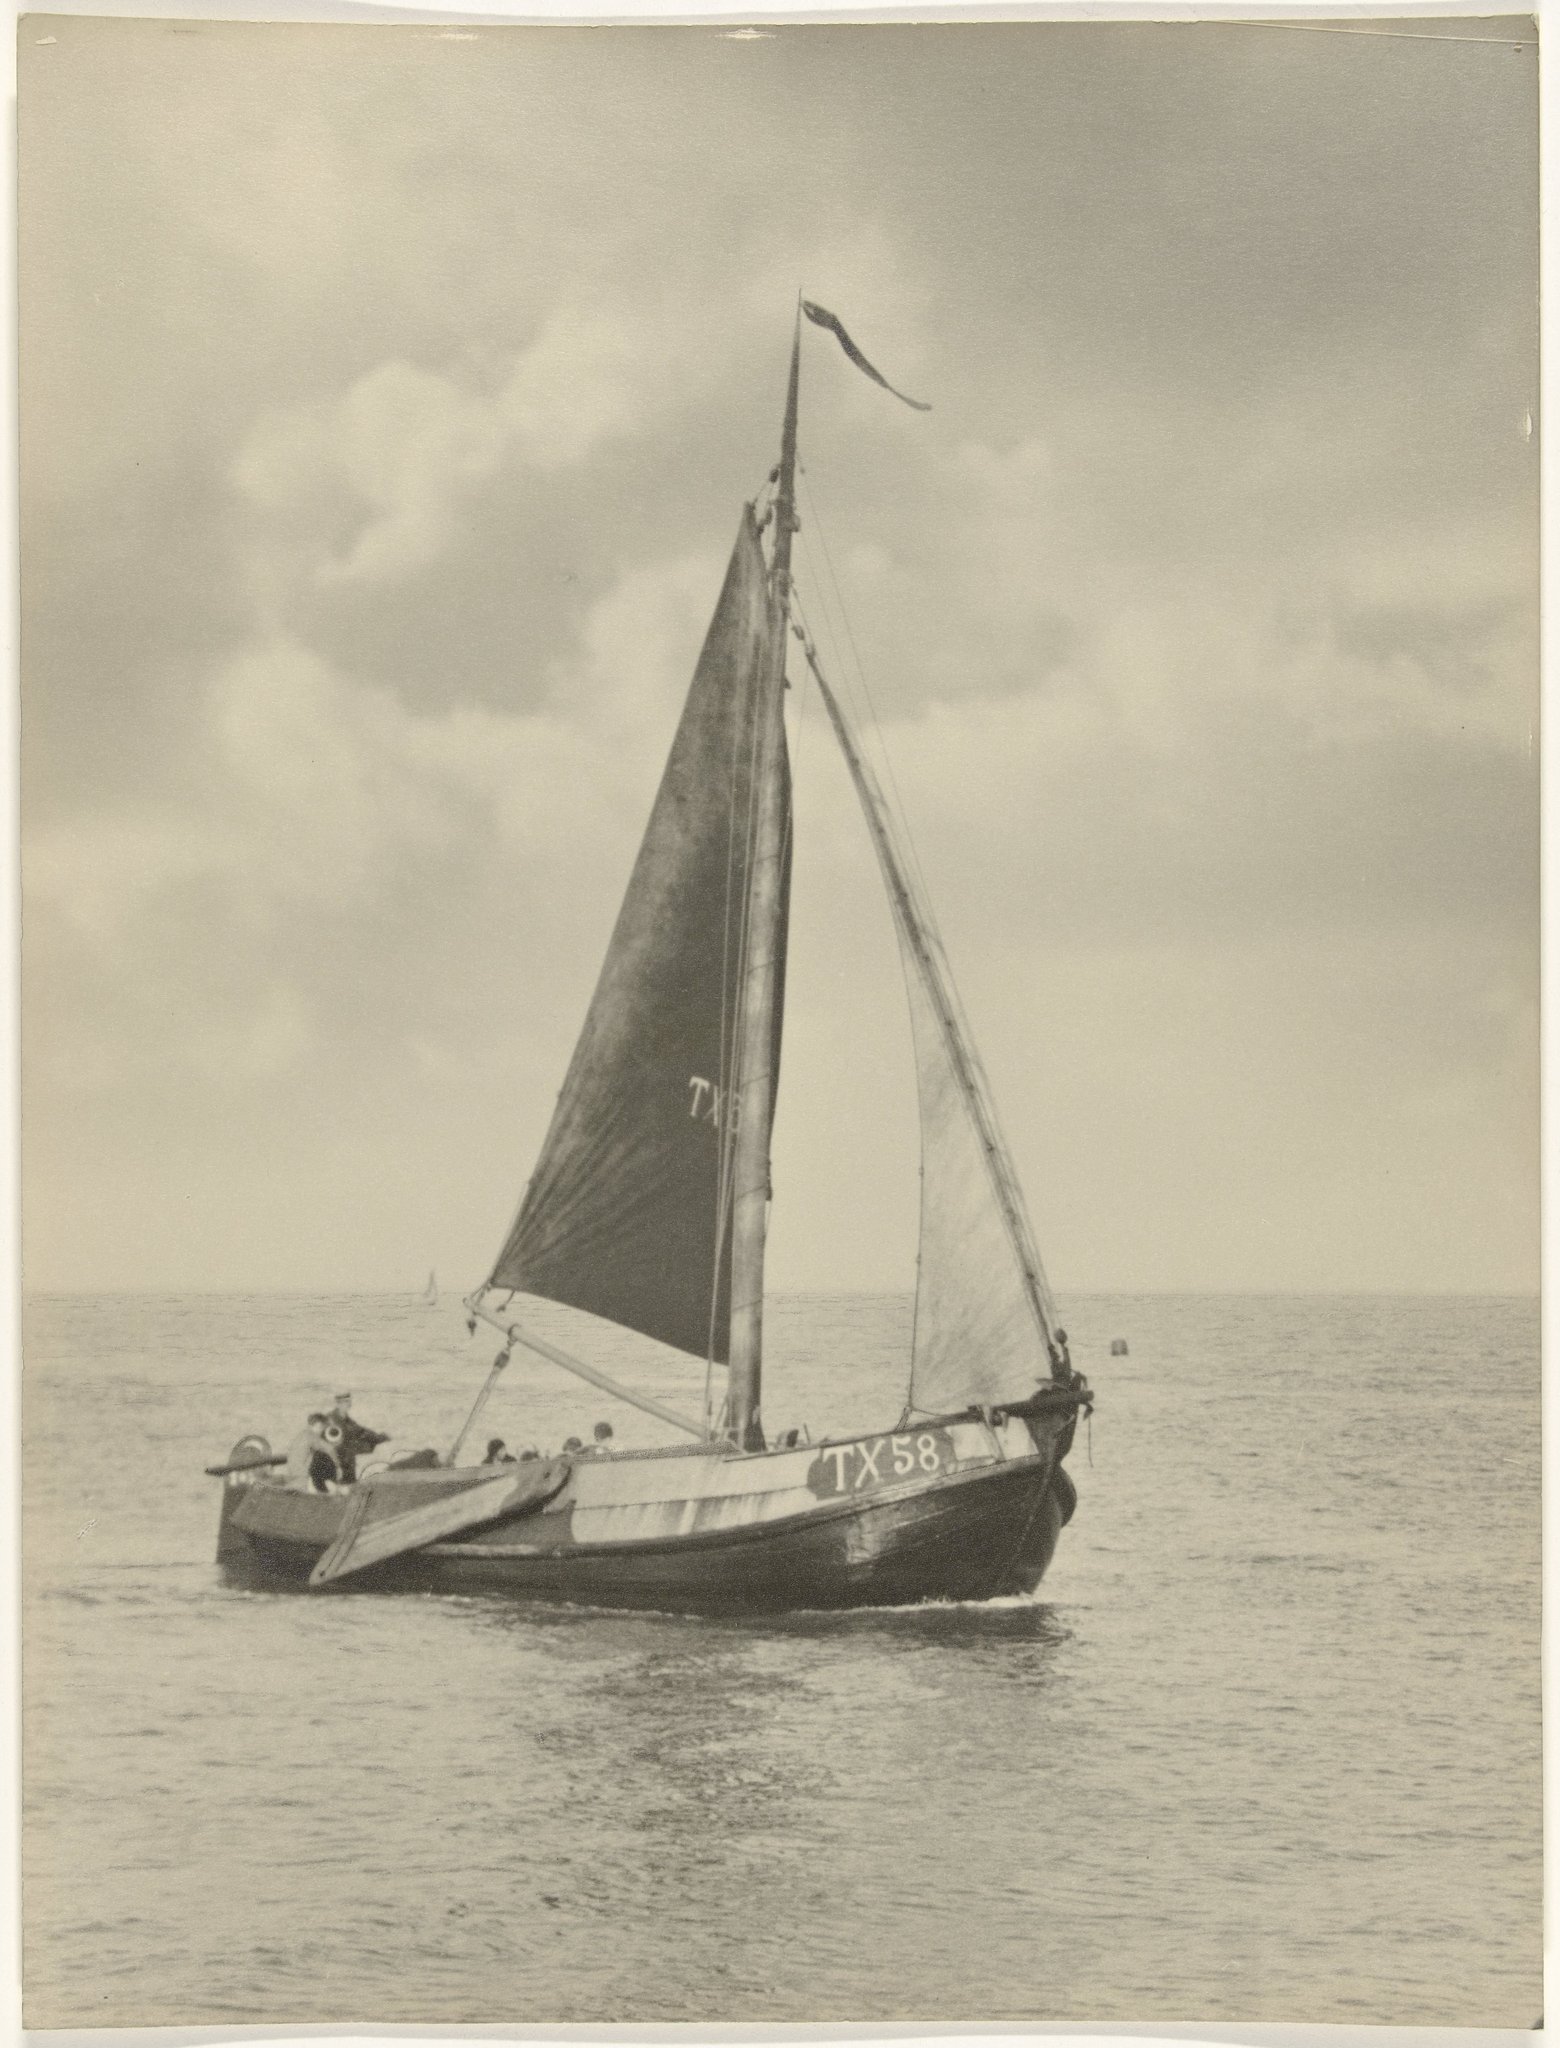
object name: photograph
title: Vissersboot TX 58 op zee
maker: h. willemse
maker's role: fotograaf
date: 1934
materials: photographic support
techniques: gelatin silver print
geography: den helder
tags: boat propelled by man or animal